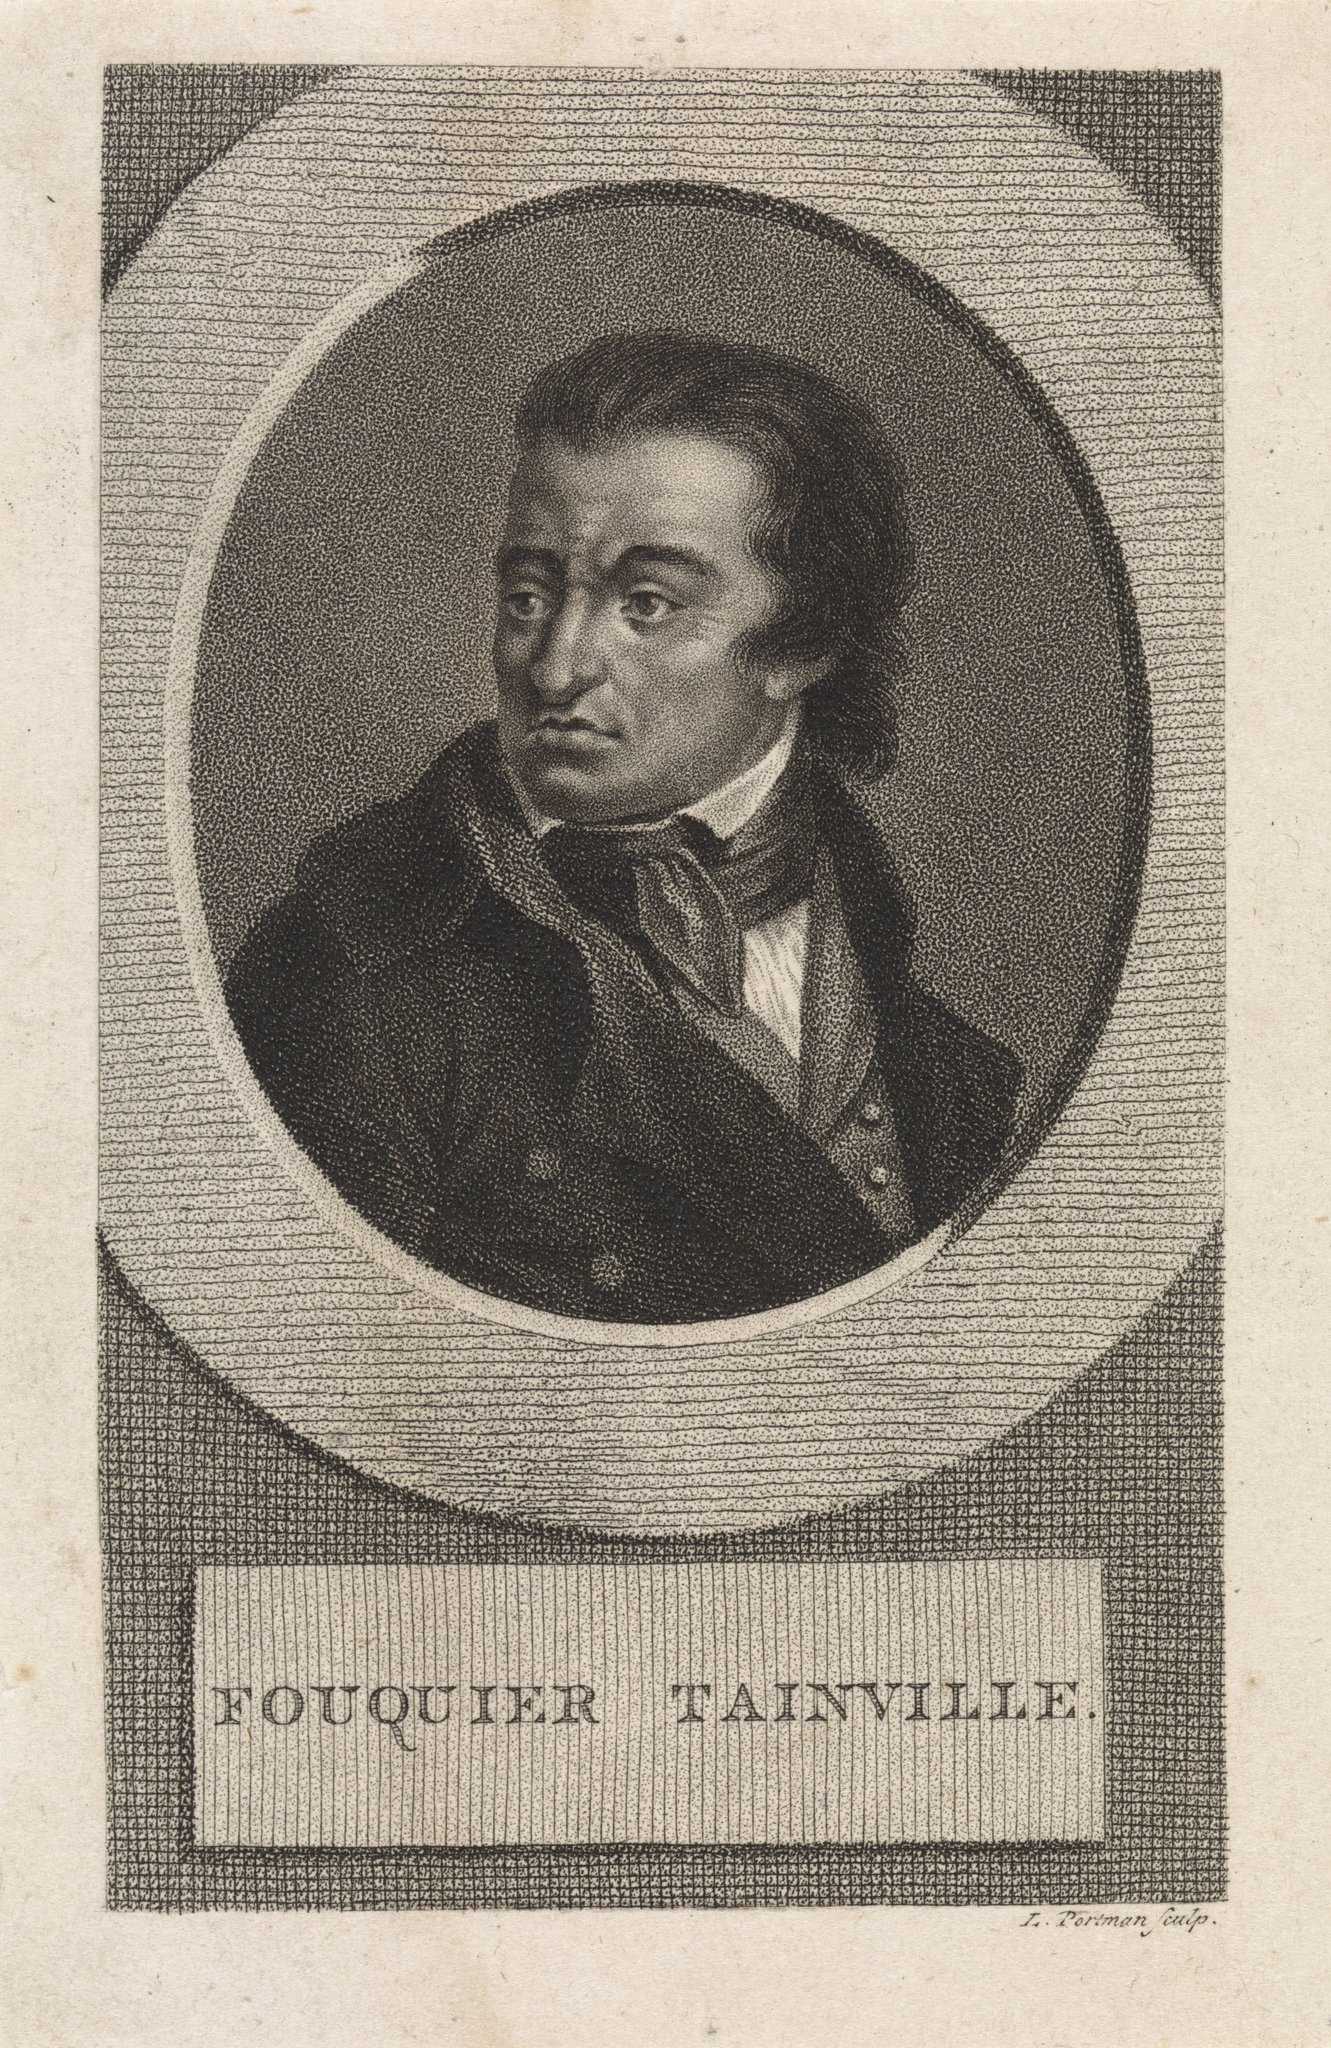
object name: print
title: Portret van de Franse advocaat Antoine Quentin Fouquier de Tinville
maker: ludwig gottlieb portman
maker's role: print maker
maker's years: 1772-1828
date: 1805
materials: paper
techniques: stippled etching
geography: amsterdam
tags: herouël, antoine quentin fouquier de tinville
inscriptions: collector's mark: Lugt 2228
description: Prent ook gebruikt als illustratie in: Tafereelen van de staatsomwenteling in Frankrijk, deel 20, p. 234. Amsterdam: Johannes Allart, 1805.